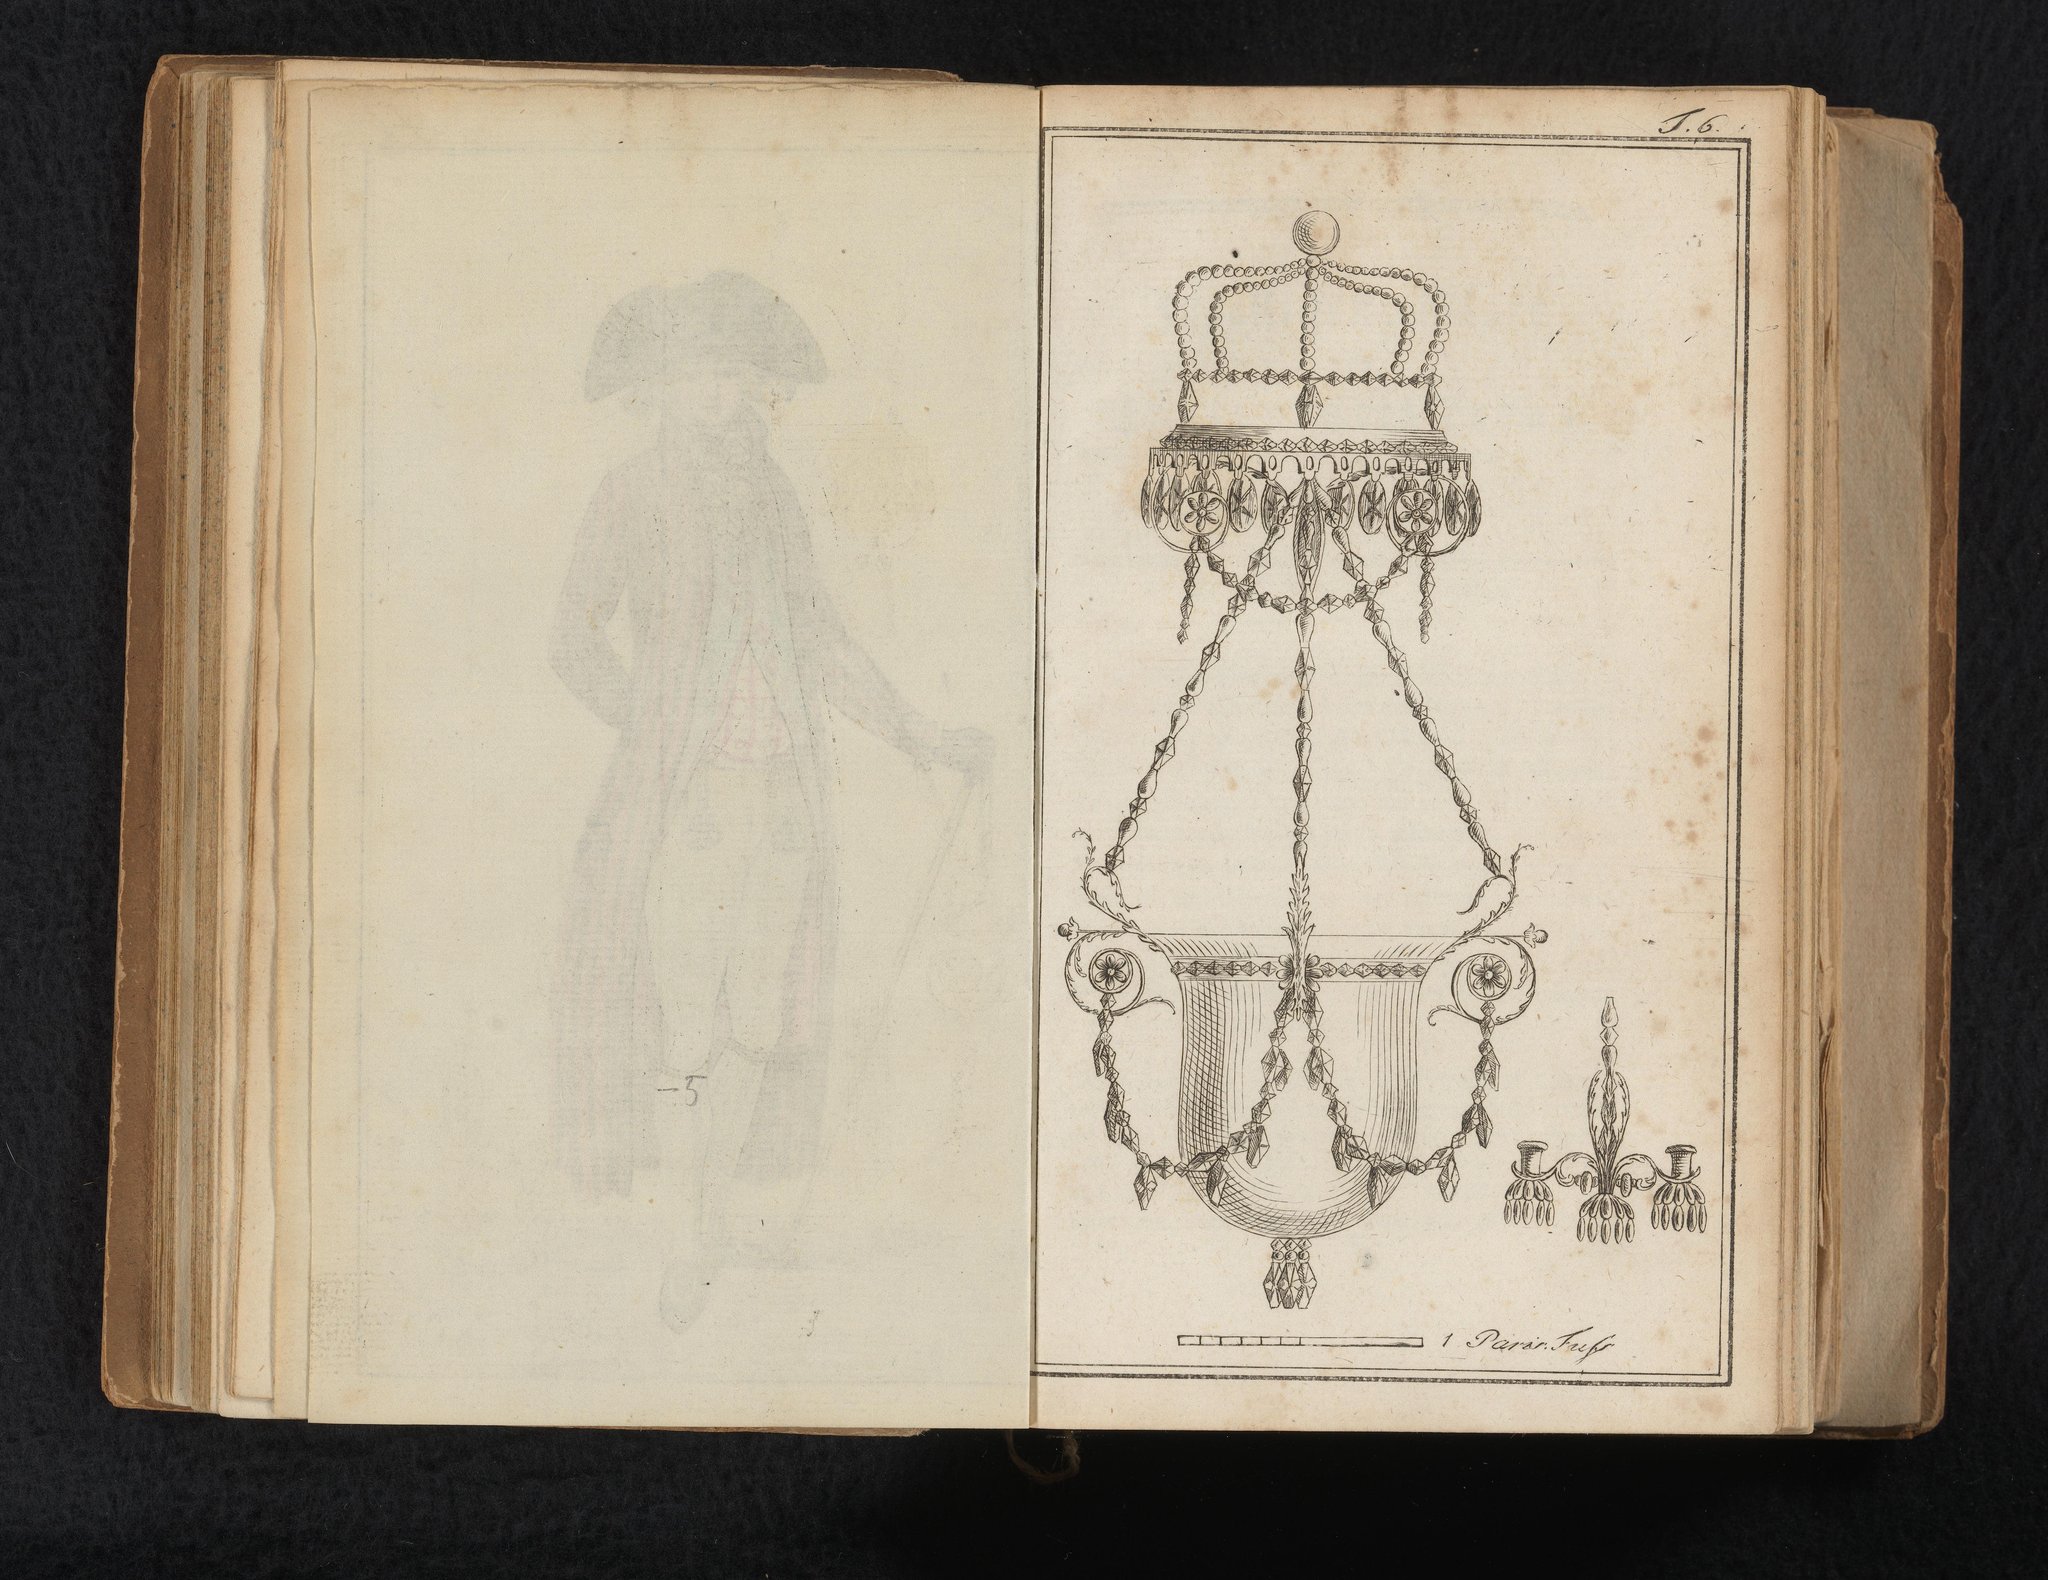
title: Journal des Luxus und der Moden 1788, Band III, T.6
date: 1788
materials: paper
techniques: etching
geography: weimar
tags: fashion plates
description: Ameublement: luchter. Prent uit het modetijdschrift Journal des Luxus und der Moden, uitgegeven door Friedrich Justin Bertuch en Georg Melchior Kraus, Weimar, 1786-1826.